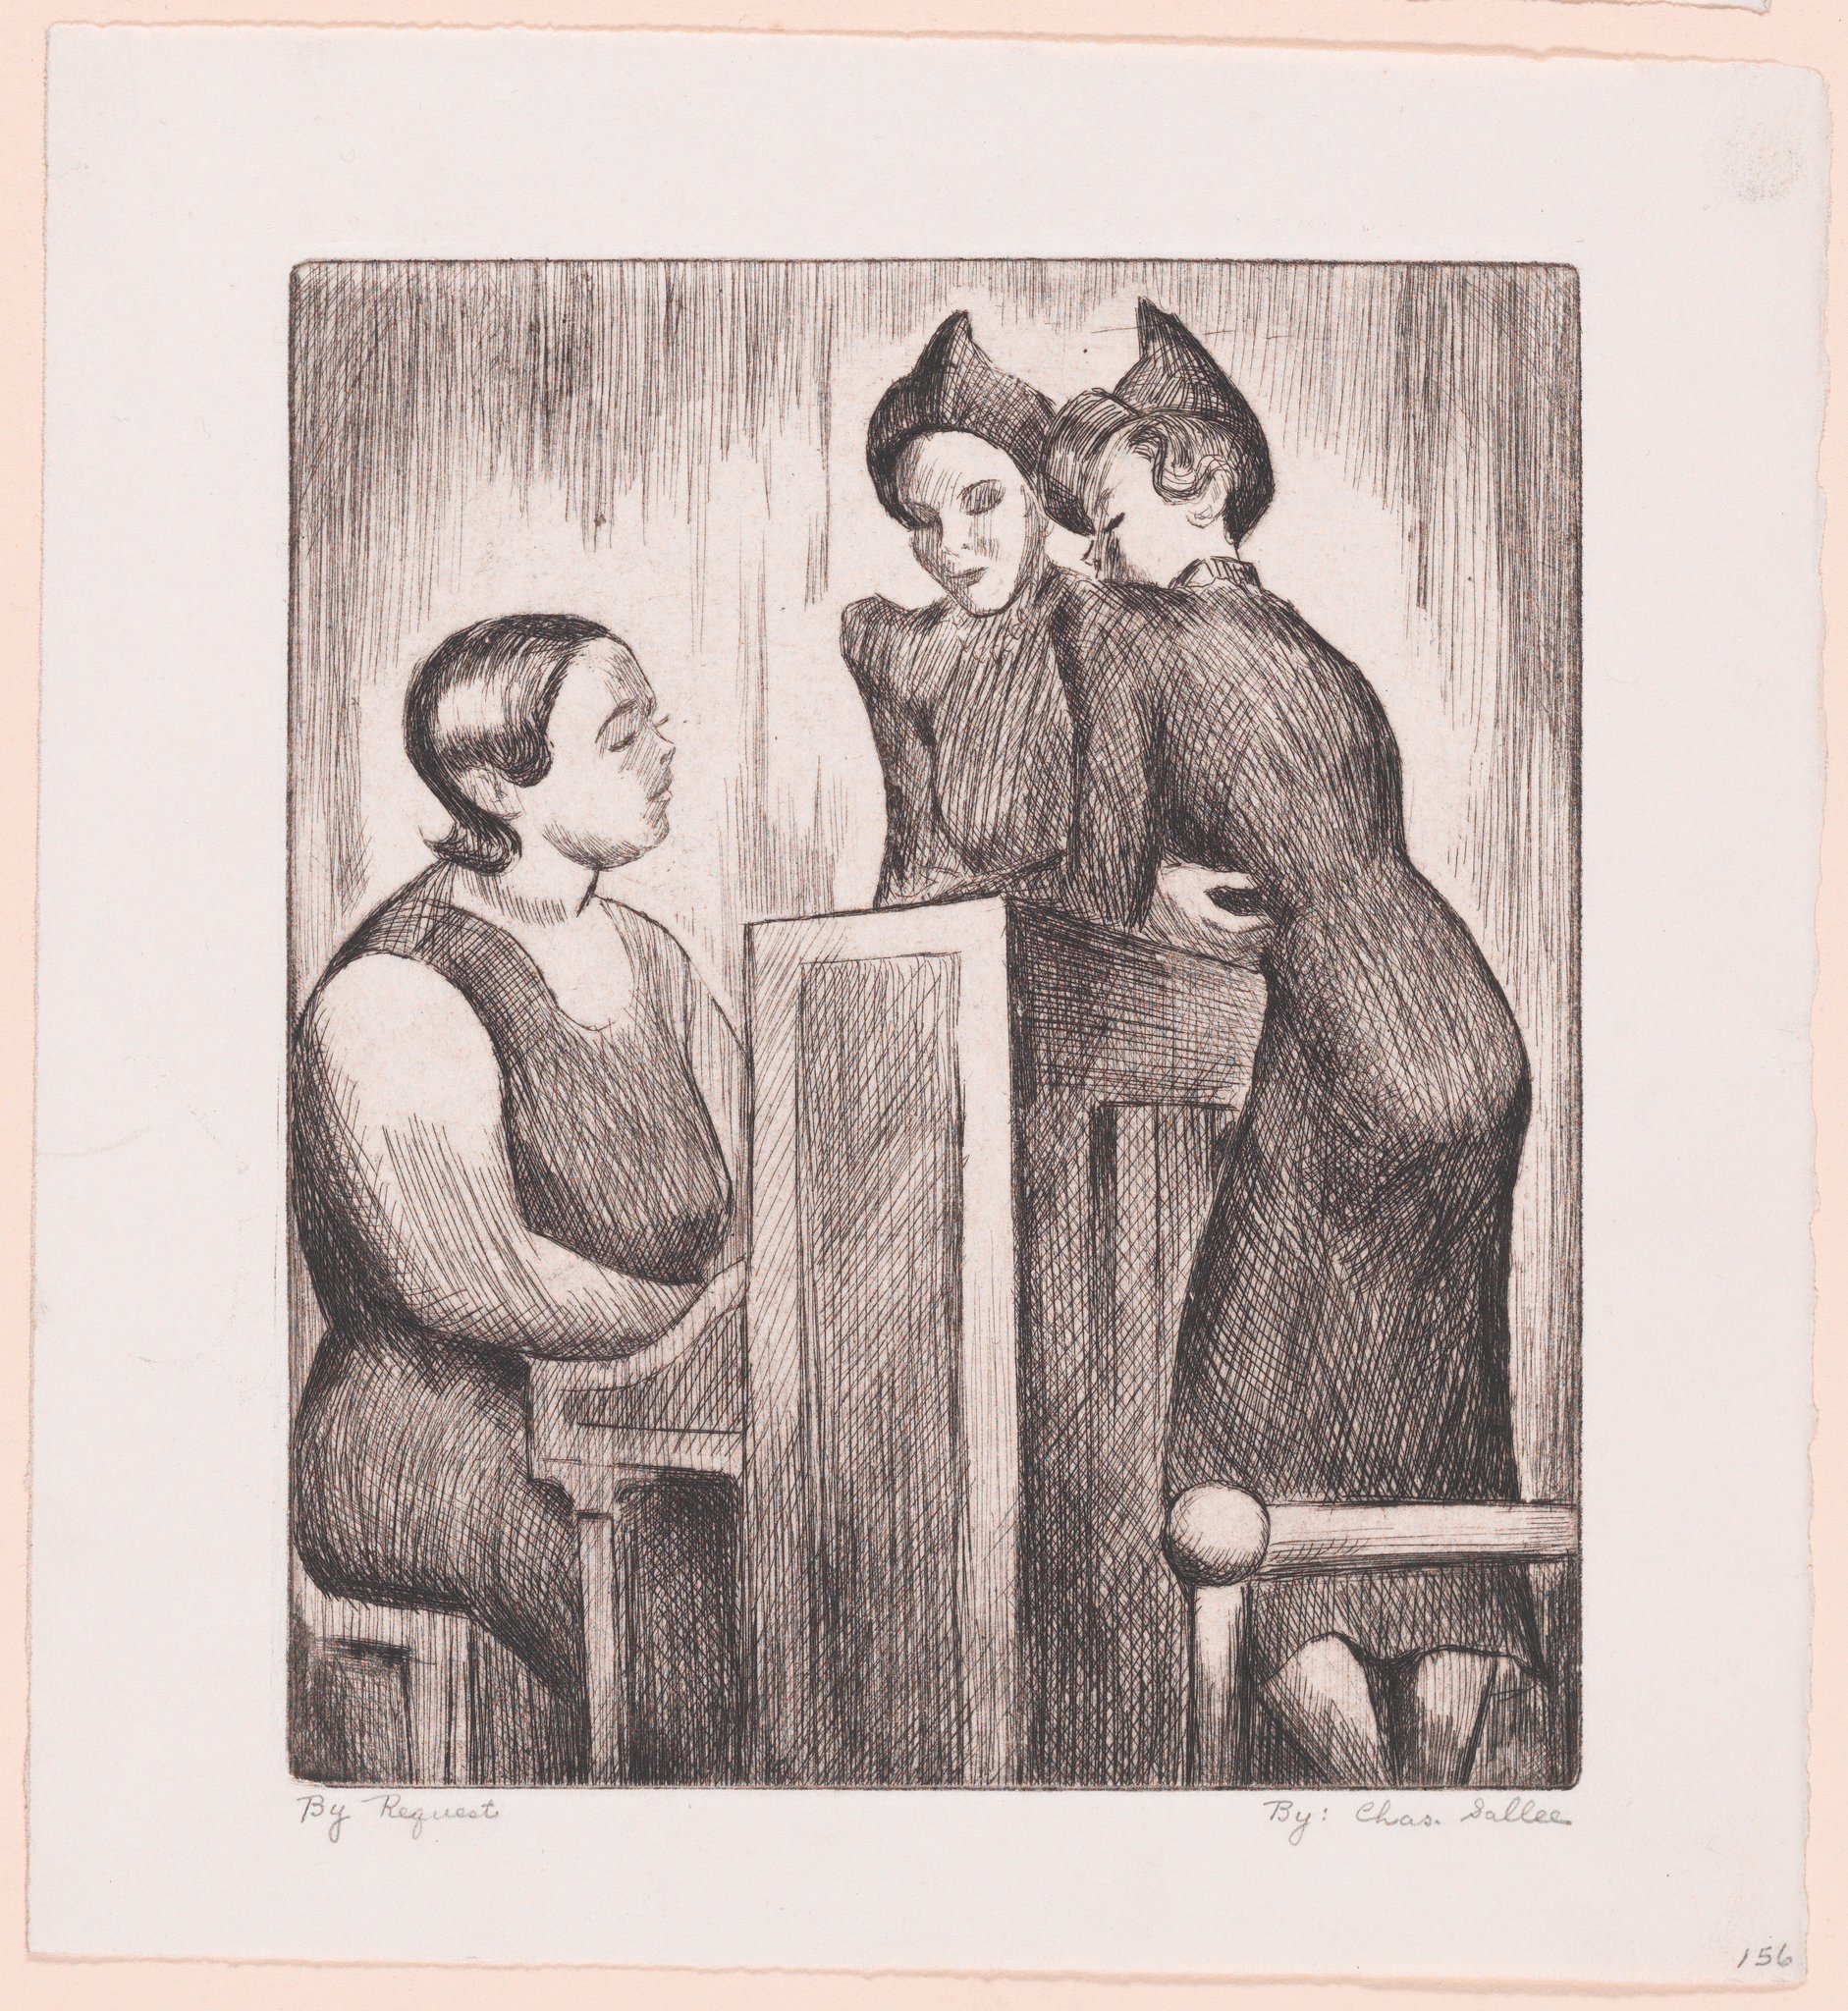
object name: print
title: By Request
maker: charles l. sallee, jr.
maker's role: artist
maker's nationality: american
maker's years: 1913-2006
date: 1936-1941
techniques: etching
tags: women,pianos,musicians